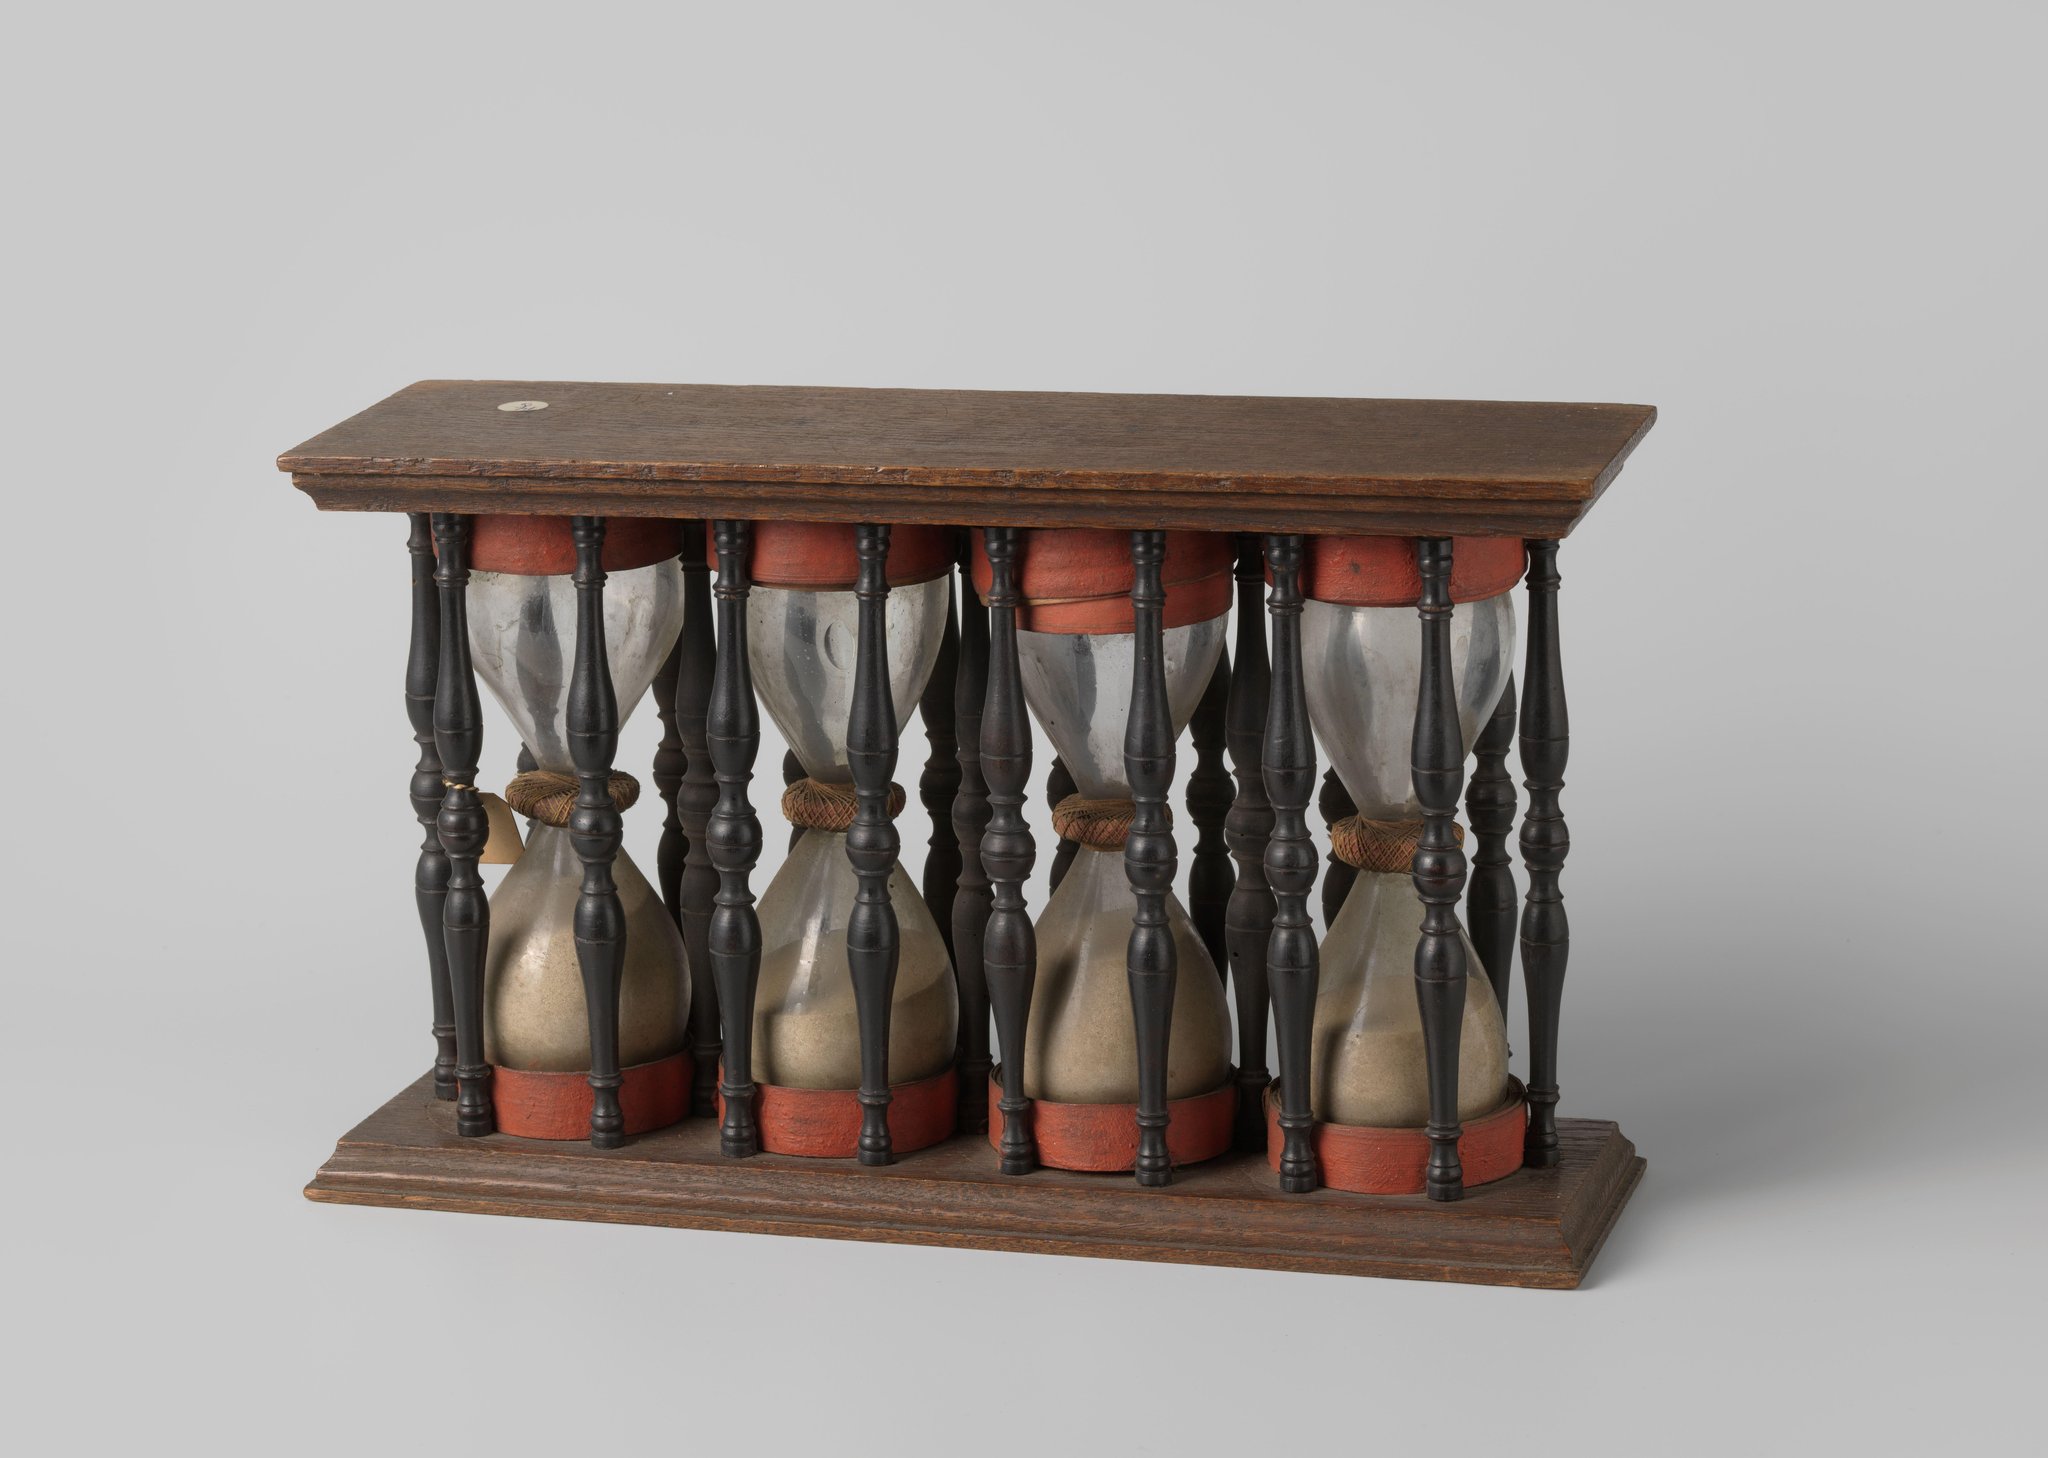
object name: sandglass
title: Zandloper met vier glazen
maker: Anonymous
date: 1600-1699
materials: wood, glass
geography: netherlands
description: Een zandloper met vier glazen die gevat zijn tussen gedraaide spijlen. Dichte boven- en onderkant.